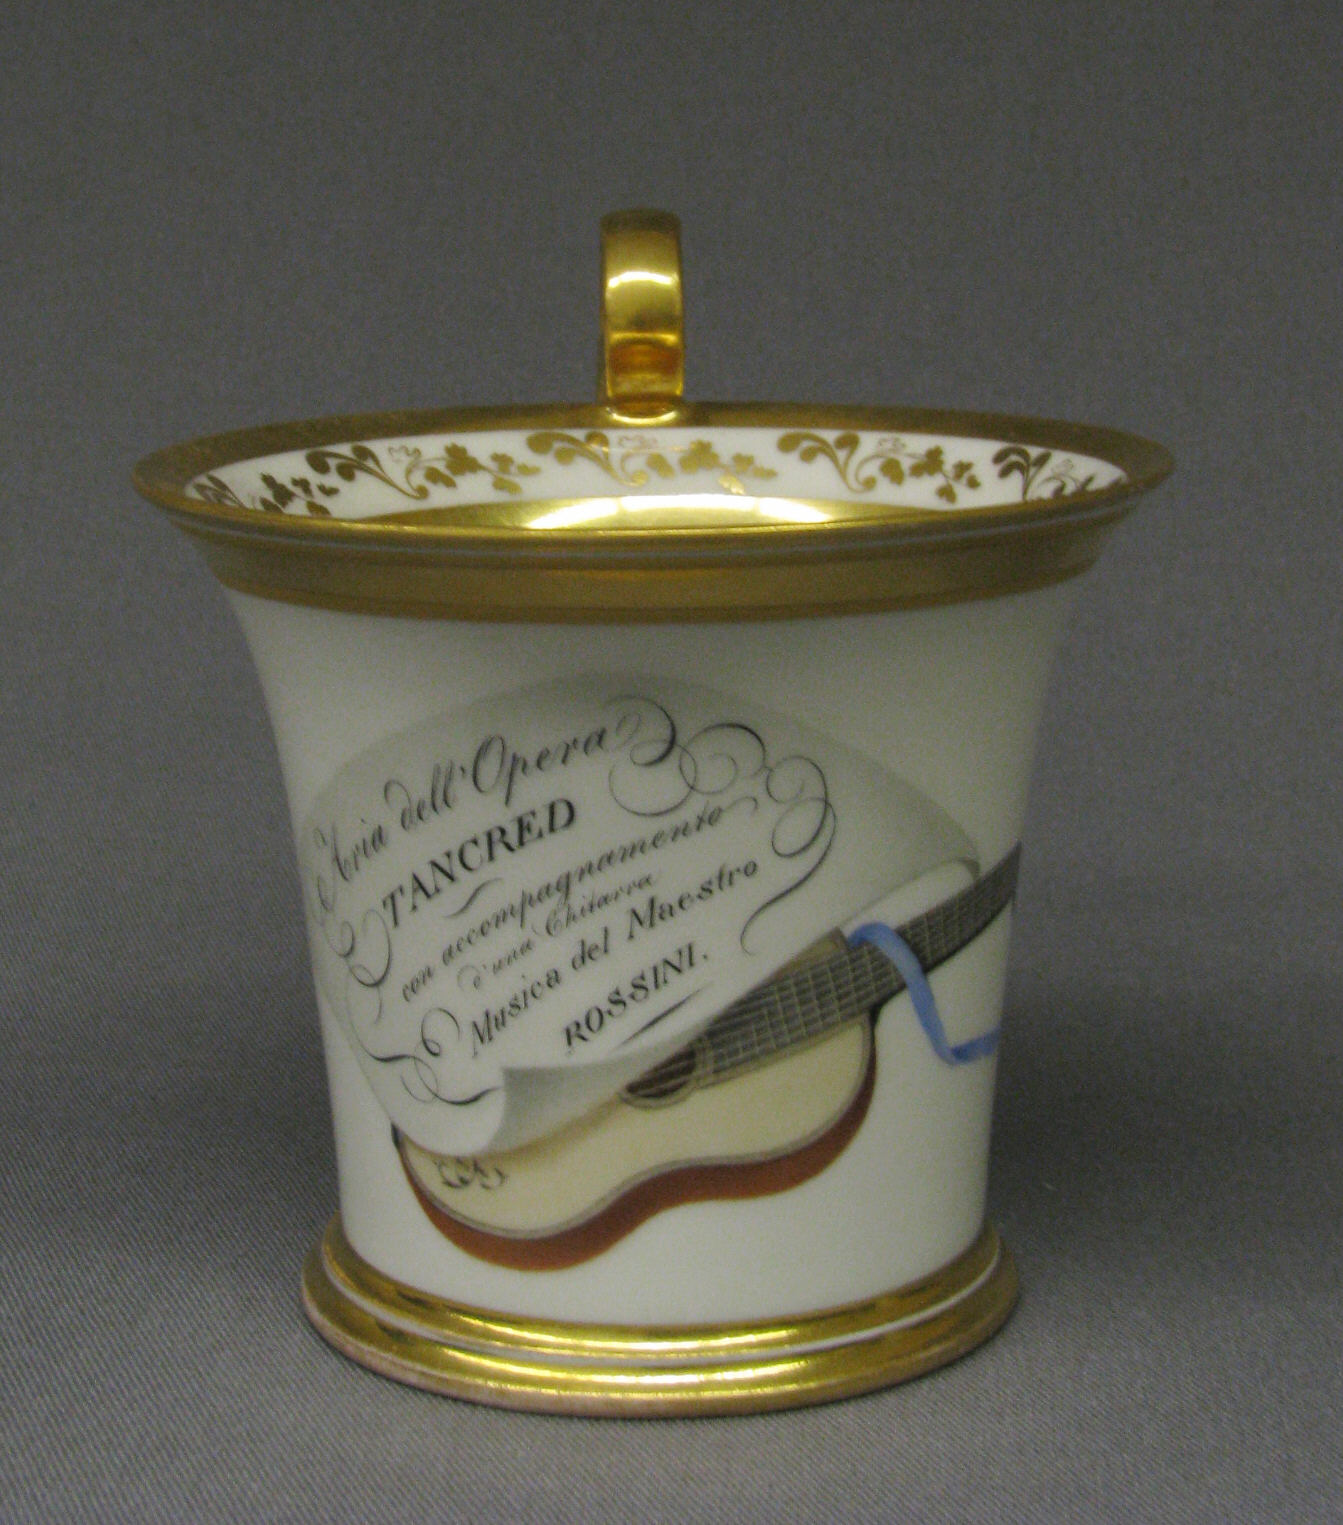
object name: cup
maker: imperial porcelain manufactory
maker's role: manufactory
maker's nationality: austrian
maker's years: 1744-1864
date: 1817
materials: hard paste porcelain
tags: music,guitars